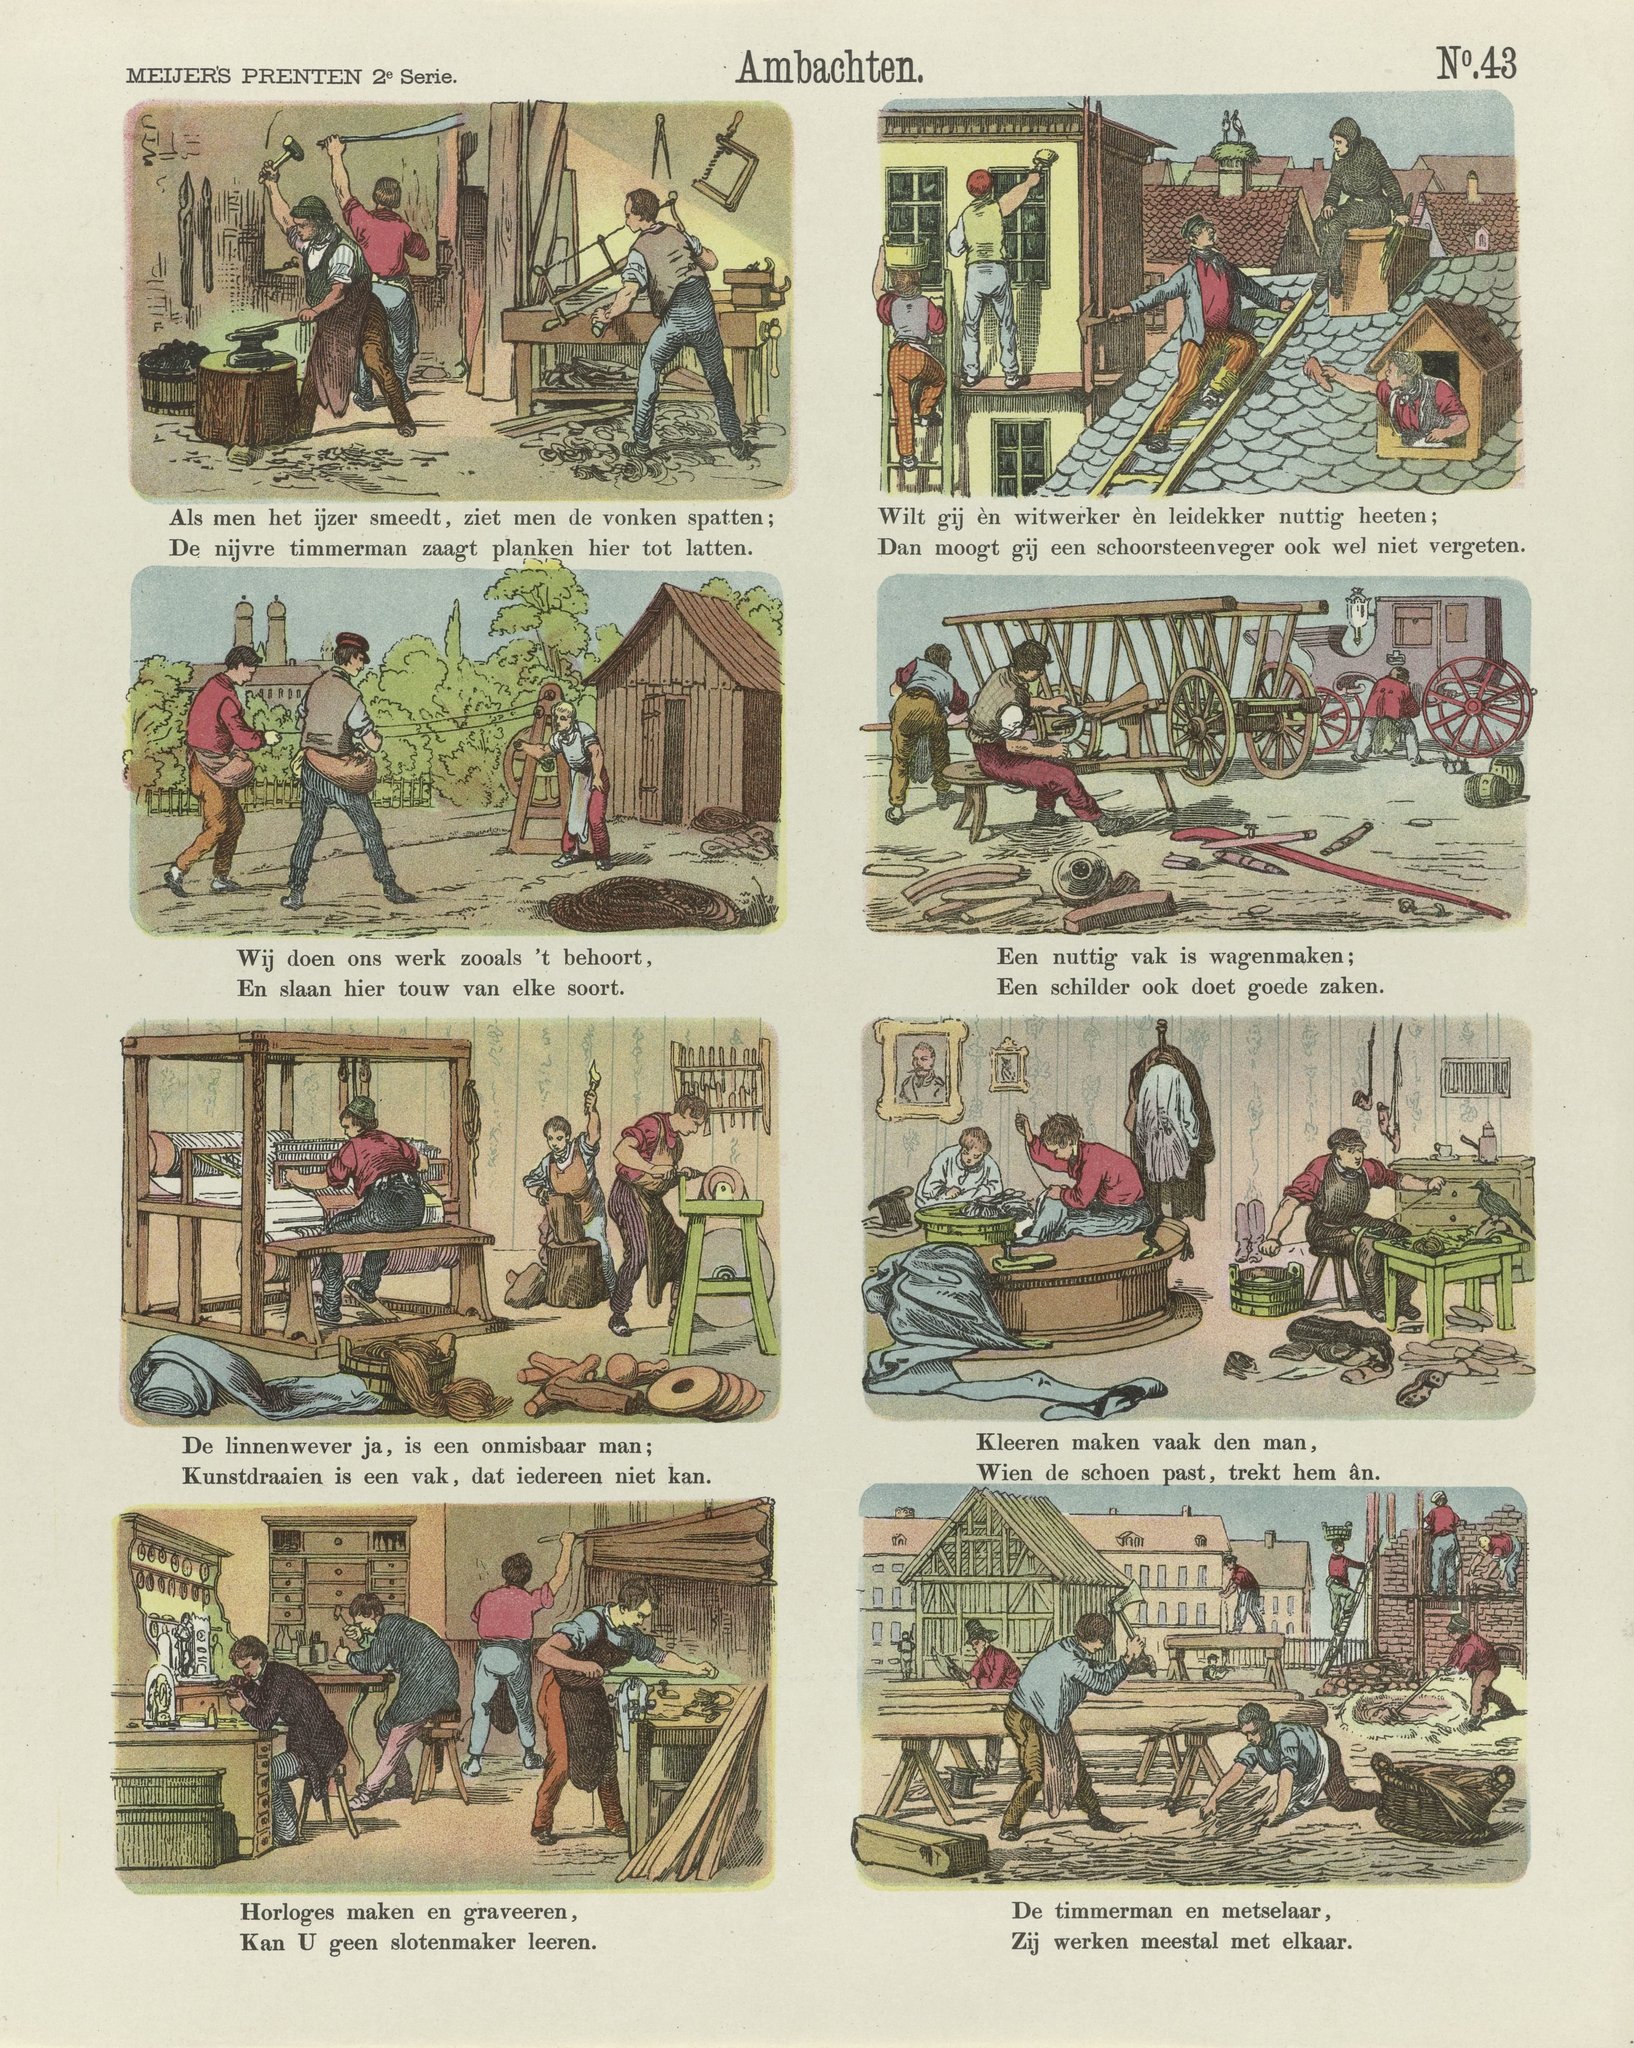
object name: popular print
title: Meijer's prenten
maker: Anonymous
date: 1874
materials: paper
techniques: lithograph, letterpress printing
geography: amsterdam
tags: craft-production, skilled handiwork, weaving, crafts and industries, watchmaker, clockmaker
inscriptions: collector's mark: Lugt 2760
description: Blad met 8 voorstellingen van verschillende ambachtslieden, zoals leidekker, wagenmaker, linnenwever en horlogemaker. Onder elke afbeelding een tweeregelig vers. Genummerd rechtsboven: No. 43.